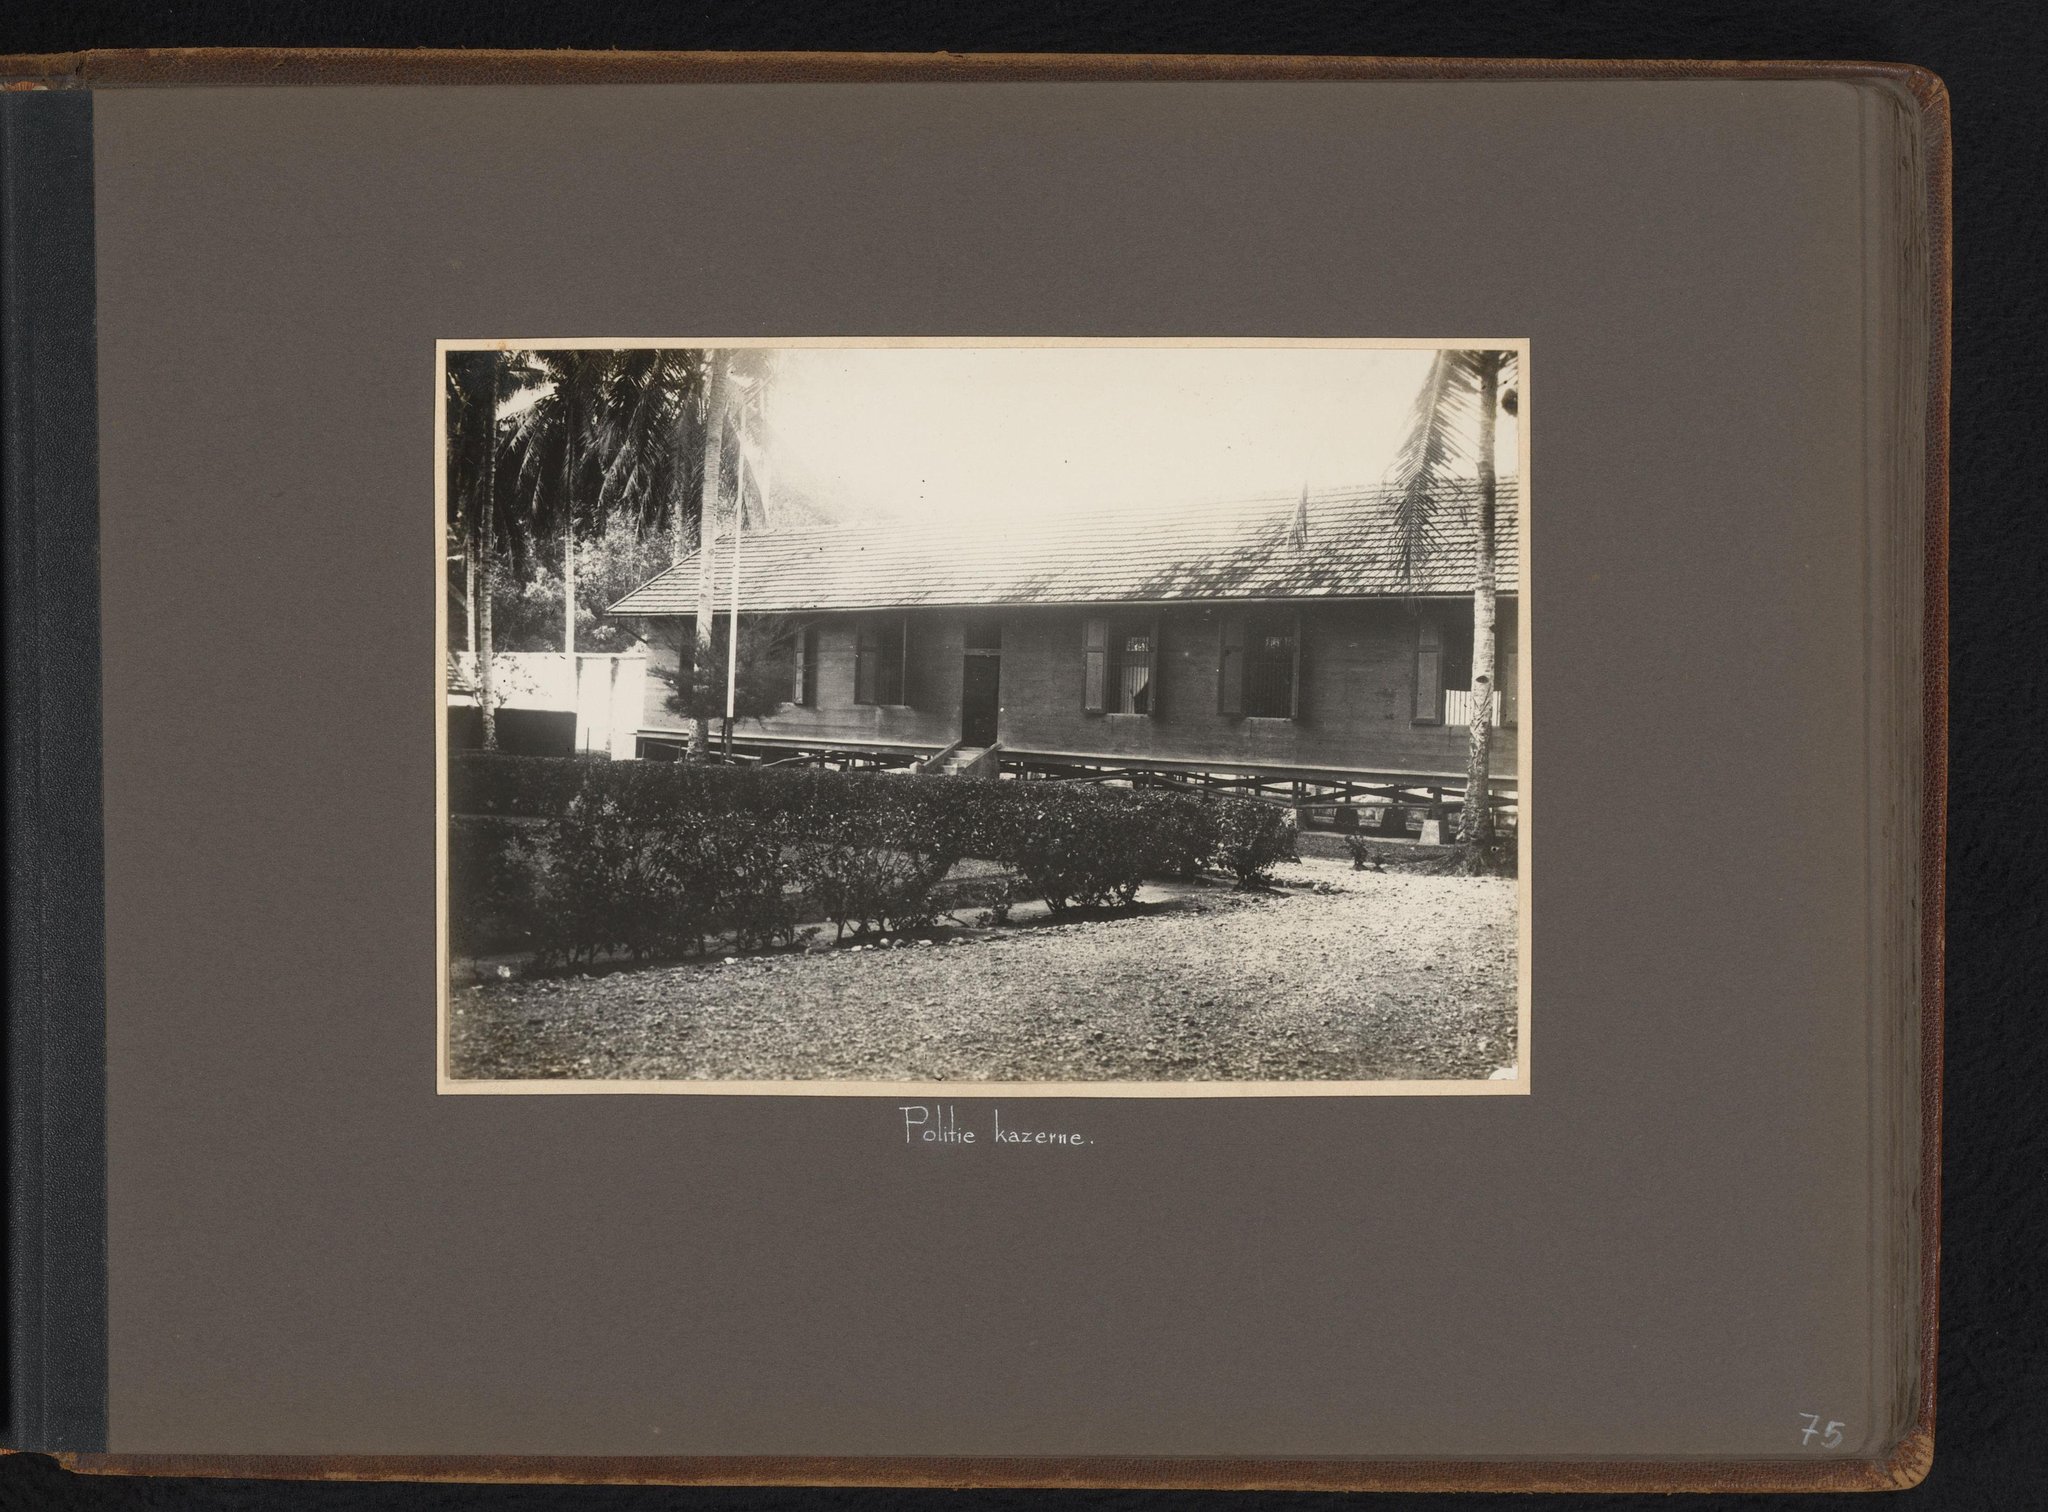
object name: album leaf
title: Politie kazerne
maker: Anonymous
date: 1925-1931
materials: cardboard, photographic support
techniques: gelatin silver print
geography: aceh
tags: sumatra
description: Albumblad met één foto: kazerne van de politie te Atjeh. Onderdeel van het fotoalbum aangeboden aan S. Koster door de Vereeniging van Hoogere Politie Ambtenaren in Nederlandsch-Indië in 1931.